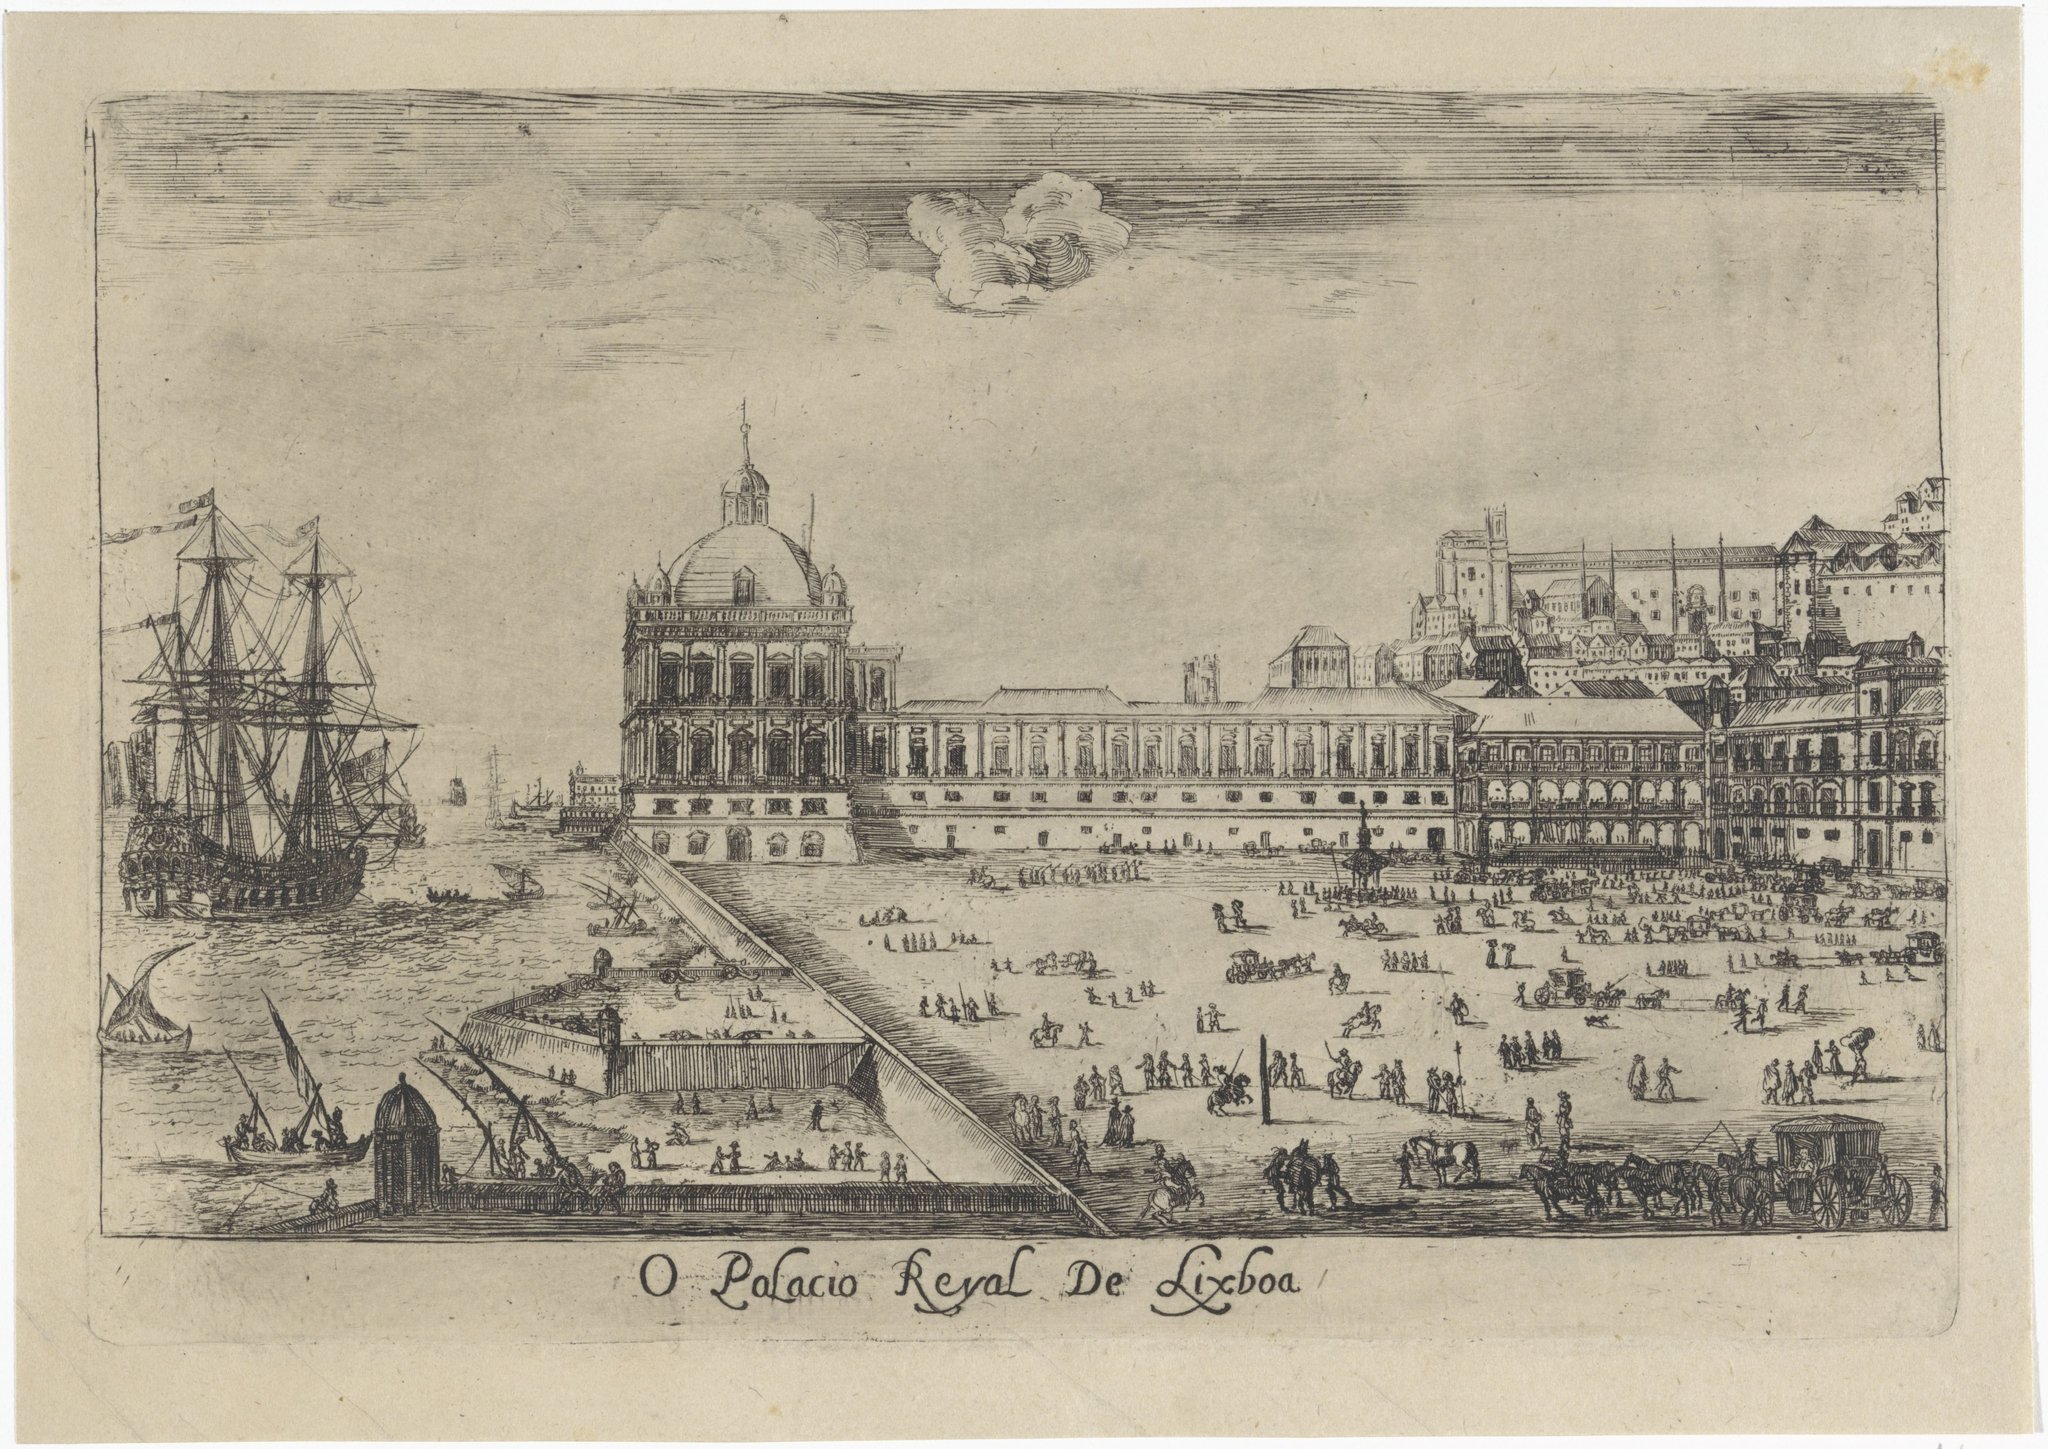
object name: print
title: Gezichten op Lissabon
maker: dirk stoop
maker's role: draughtsman, painter, print maker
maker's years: 1615-1686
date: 1662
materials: paper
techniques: etching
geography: lisbon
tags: sailing-ship, sailing-boat, city-view in general; 'veduta', palace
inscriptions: collector's mark: Lugt 2228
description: Het koninklijk paleis te Lissabon gelegen aan een groot plein en aan de rivier de Taag. Op het plein giguren en koetsen. Op het water een groot zeilschip.